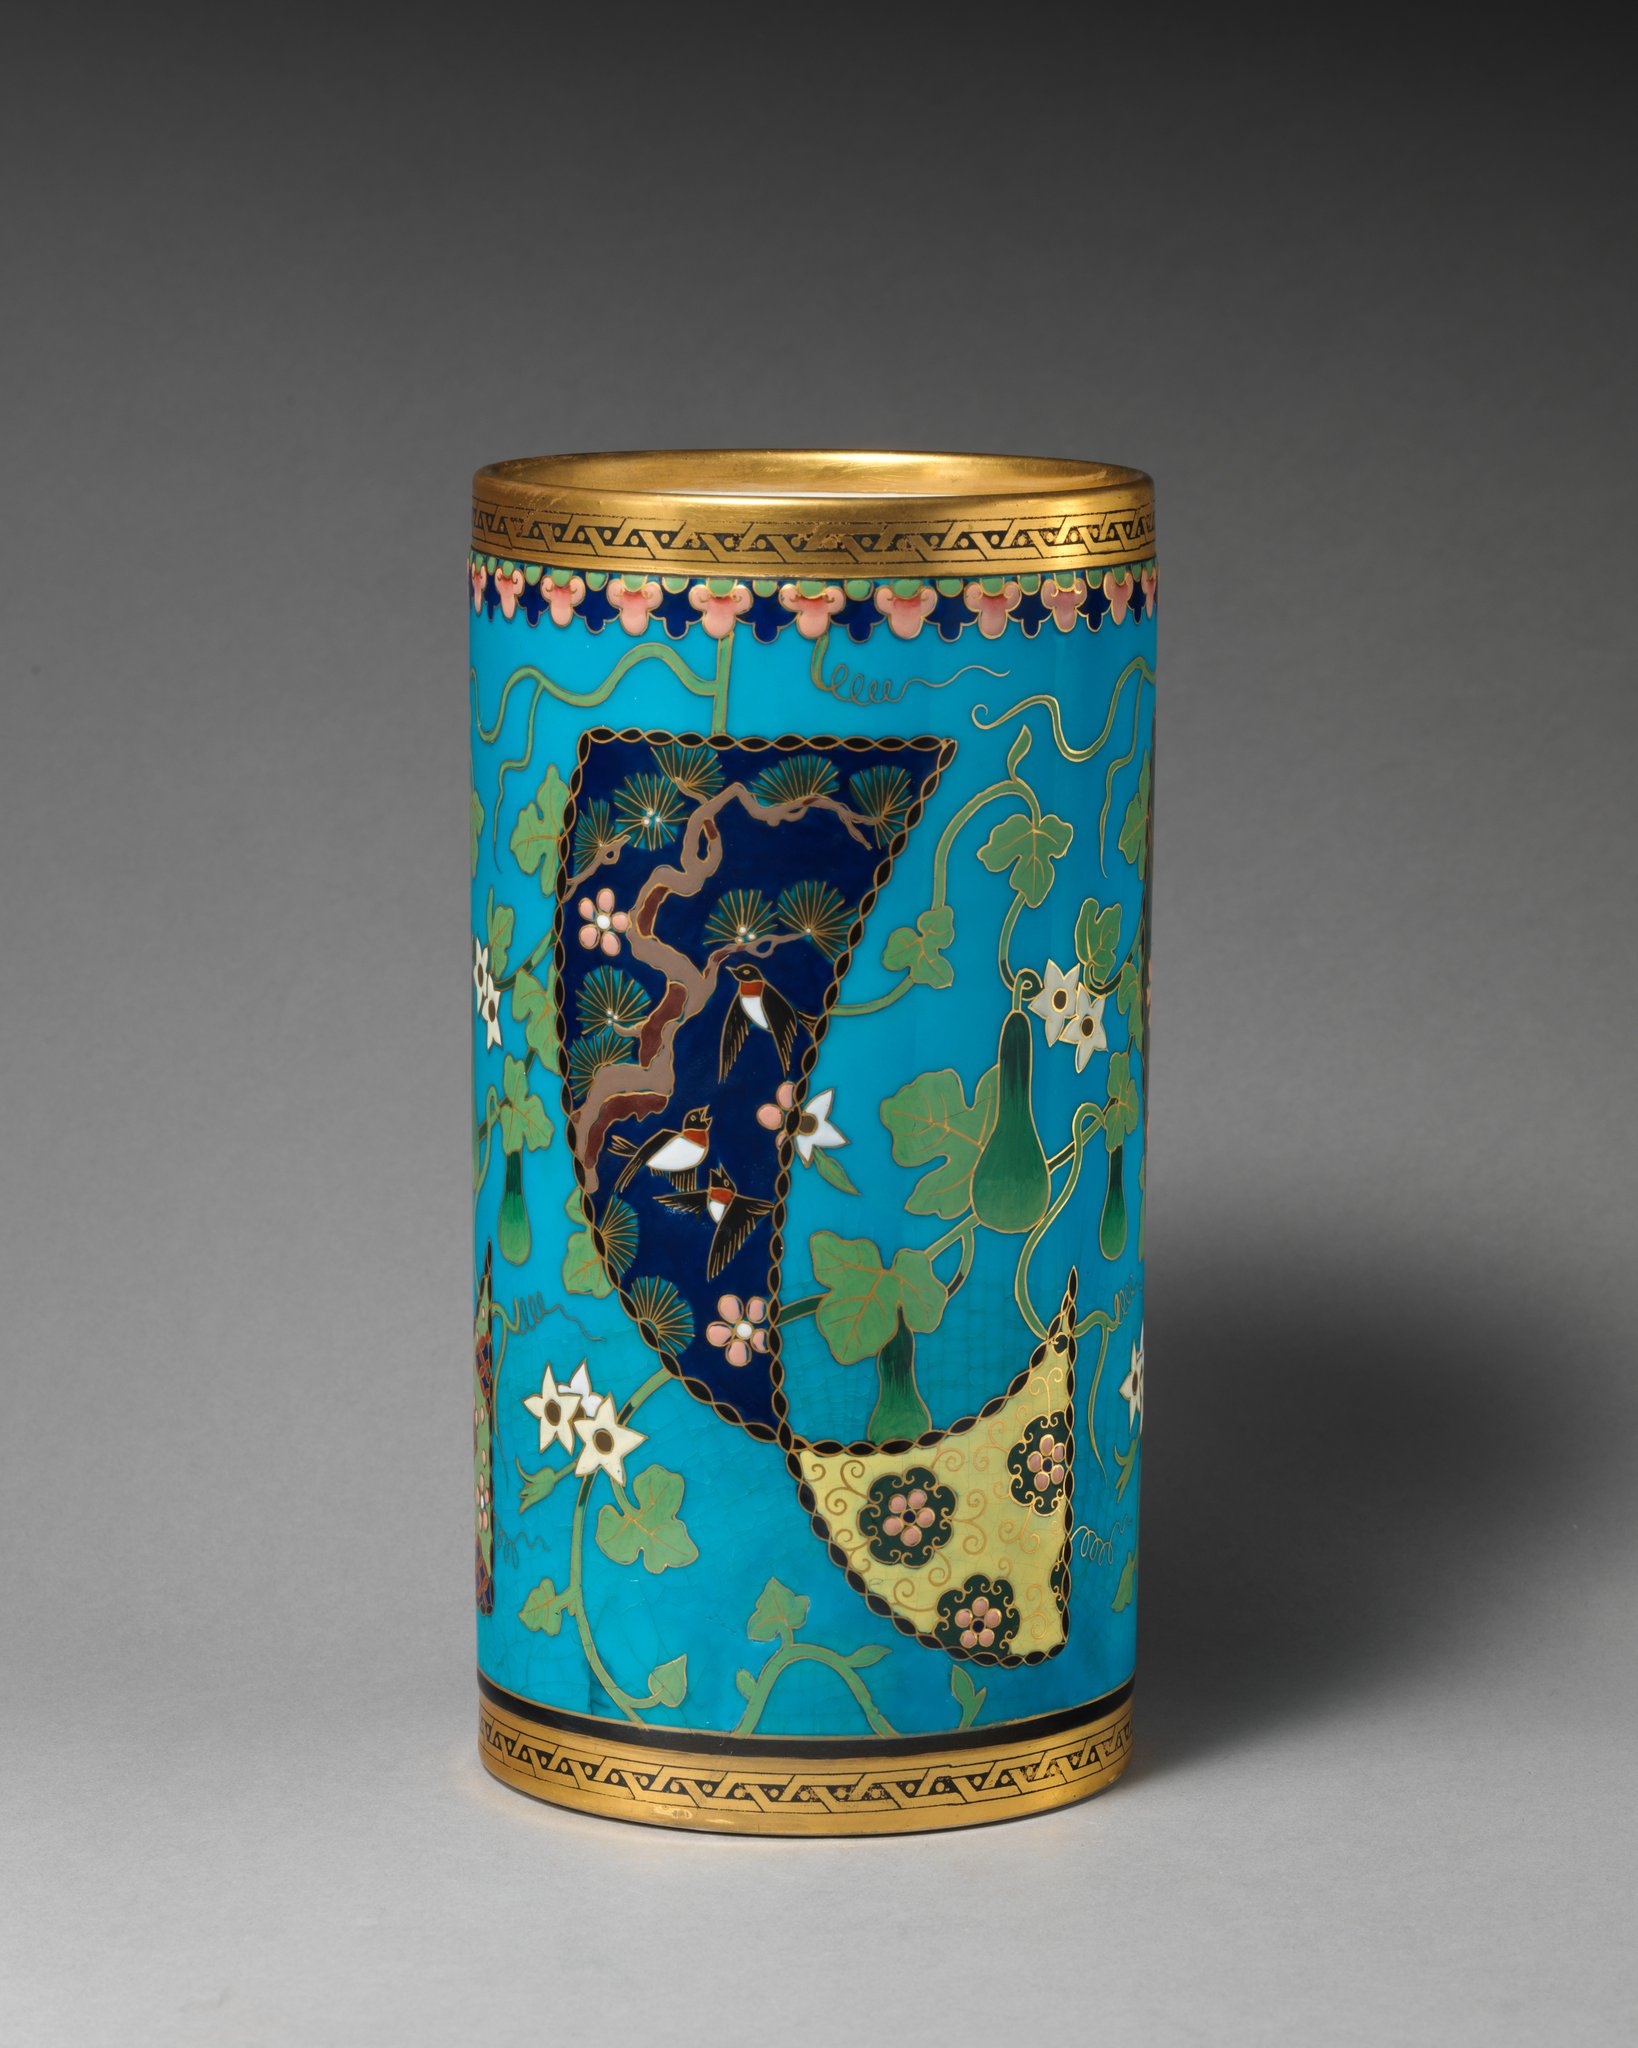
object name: vase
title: Large spill vase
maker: minton(s)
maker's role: maker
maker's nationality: british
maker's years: 1793-2001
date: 1872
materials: bone china